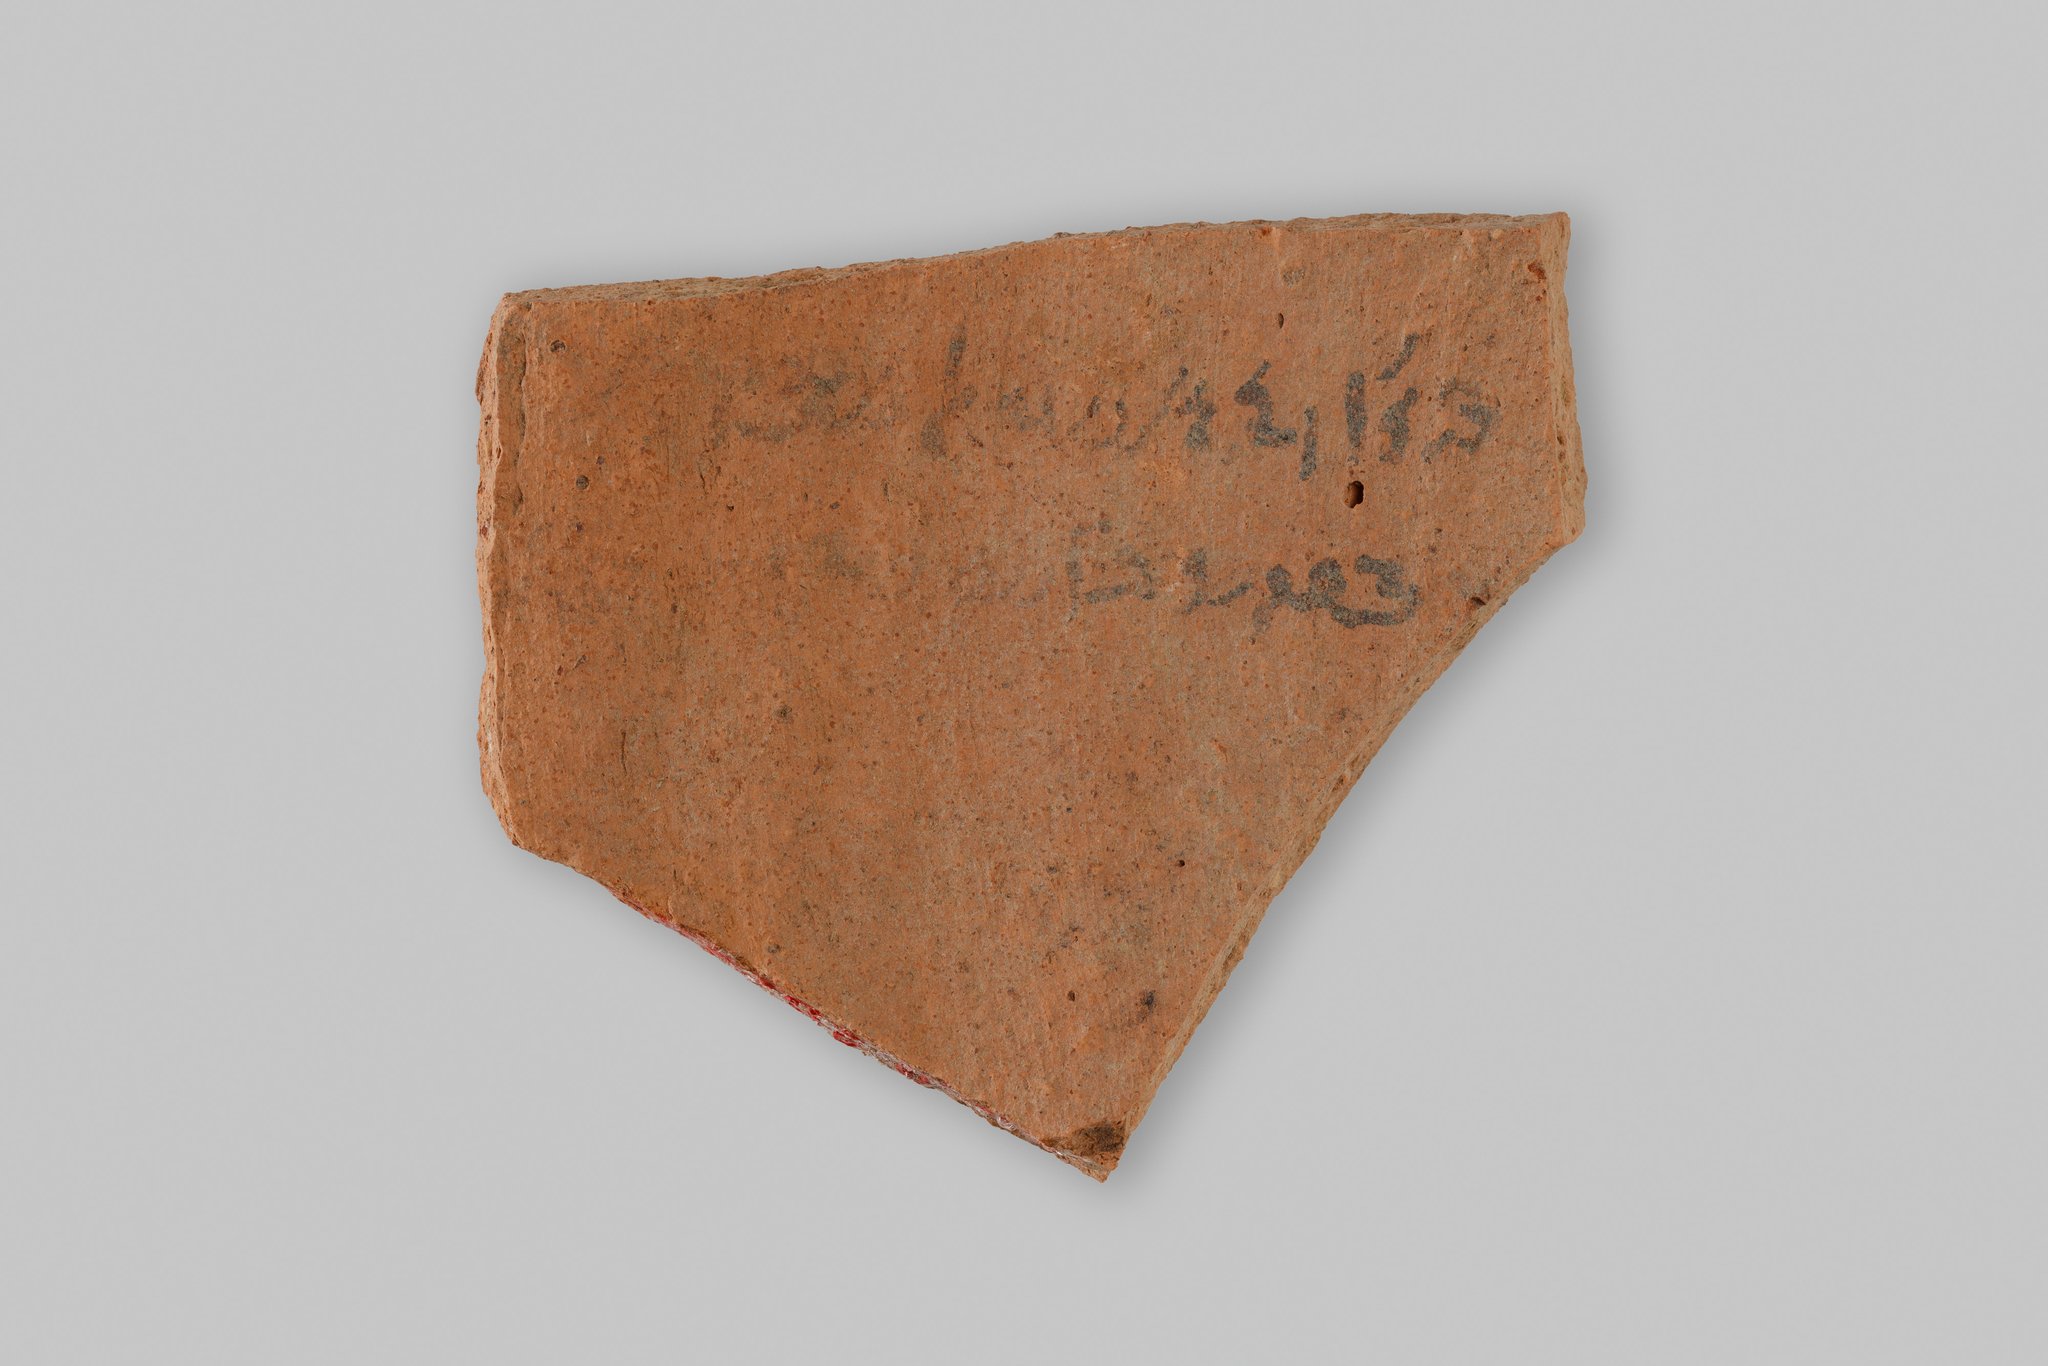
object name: ostracon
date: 400-30 BCE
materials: ink, pottery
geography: egypt